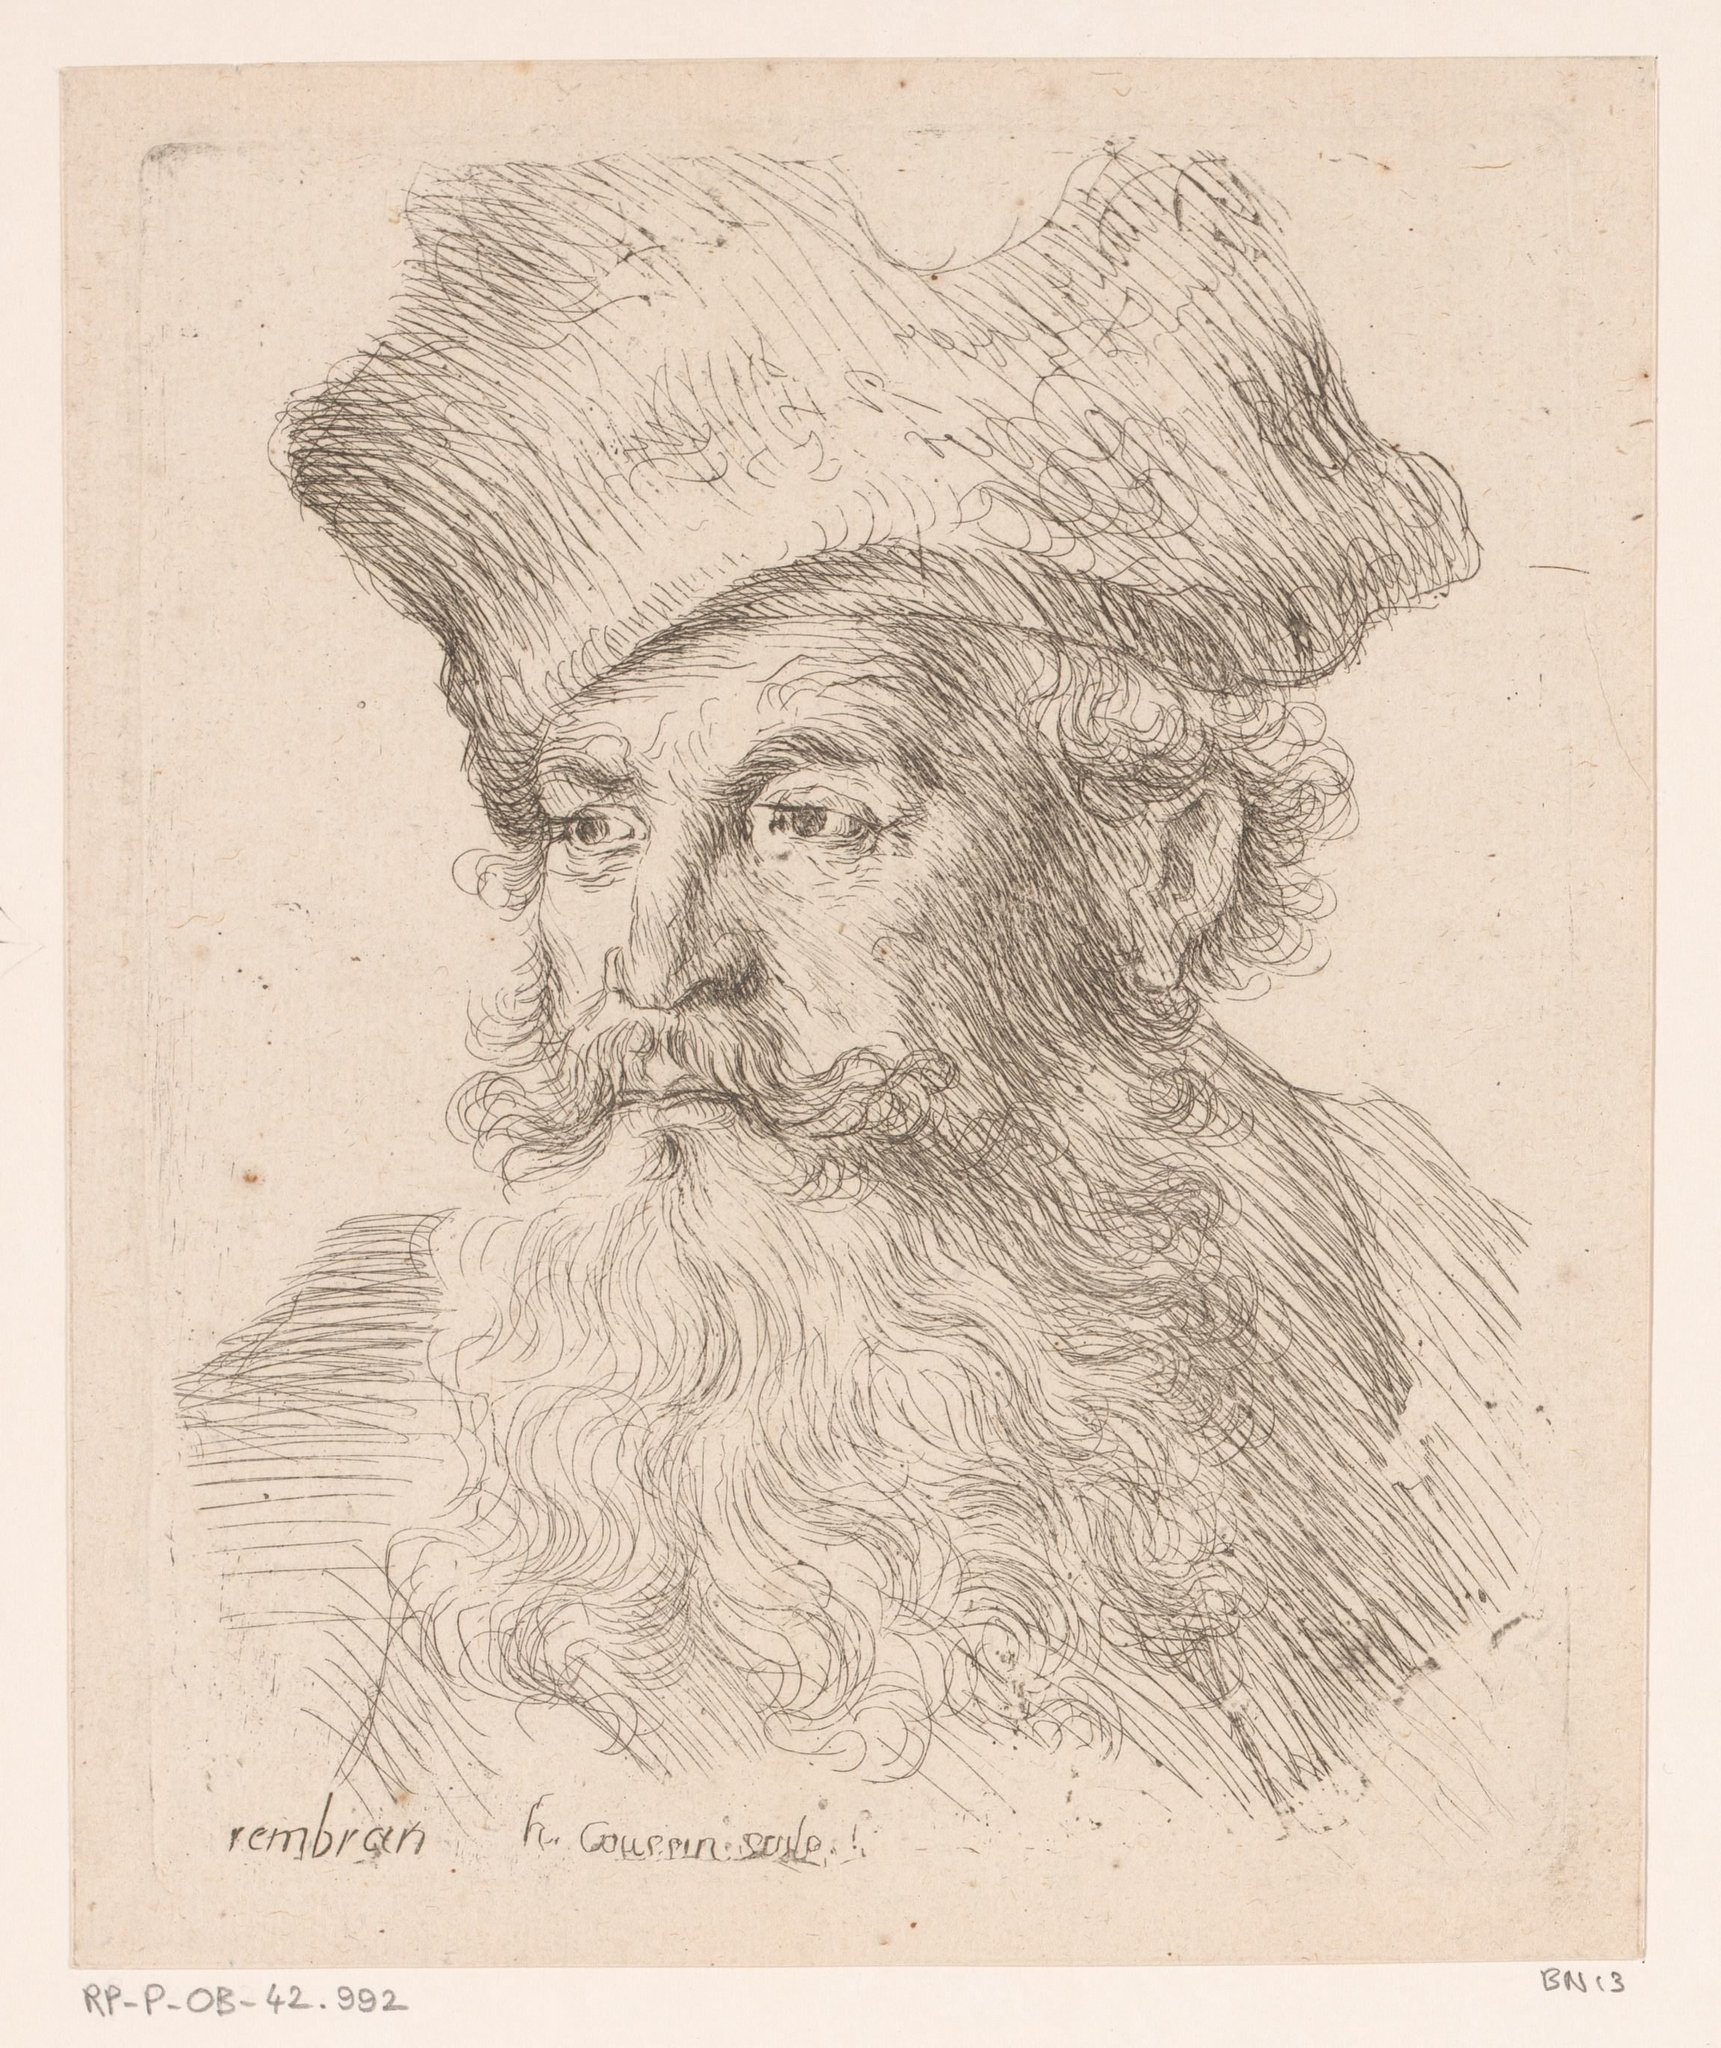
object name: print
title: Hoofd van een oude man van boven kaal en profile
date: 1708-1779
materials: paper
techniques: etching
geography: france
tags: moustache, old man, baldness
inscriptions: collector's mark: Lugt 240